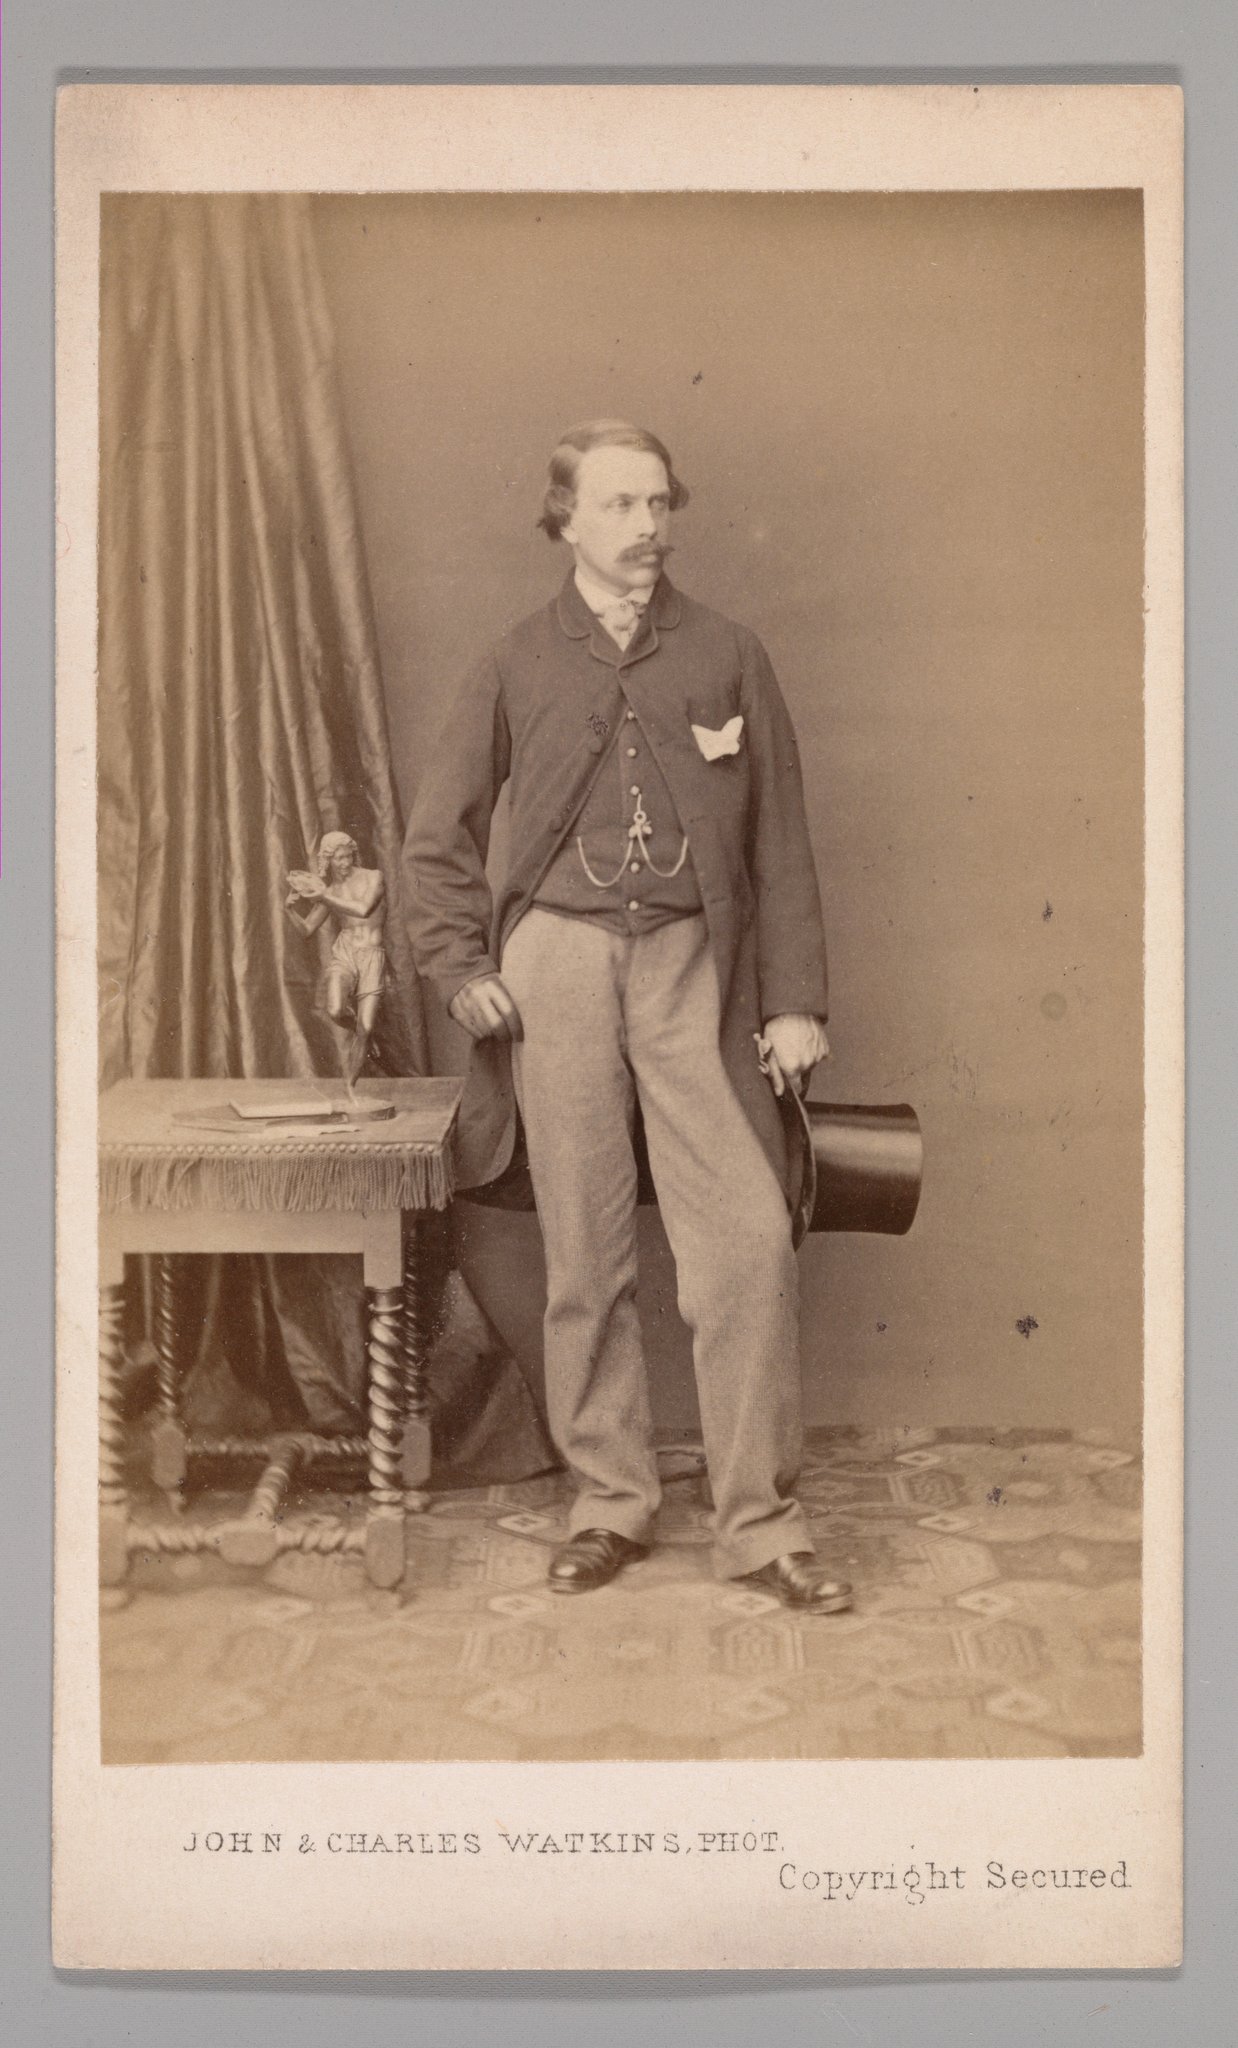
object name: carte de visite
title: [Samuel Philips Jackson]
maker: john and charles watkins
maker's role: photography studio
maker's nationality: british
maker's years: 1840-1875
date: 1860-1869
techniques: albumen silver print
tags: men,portraits